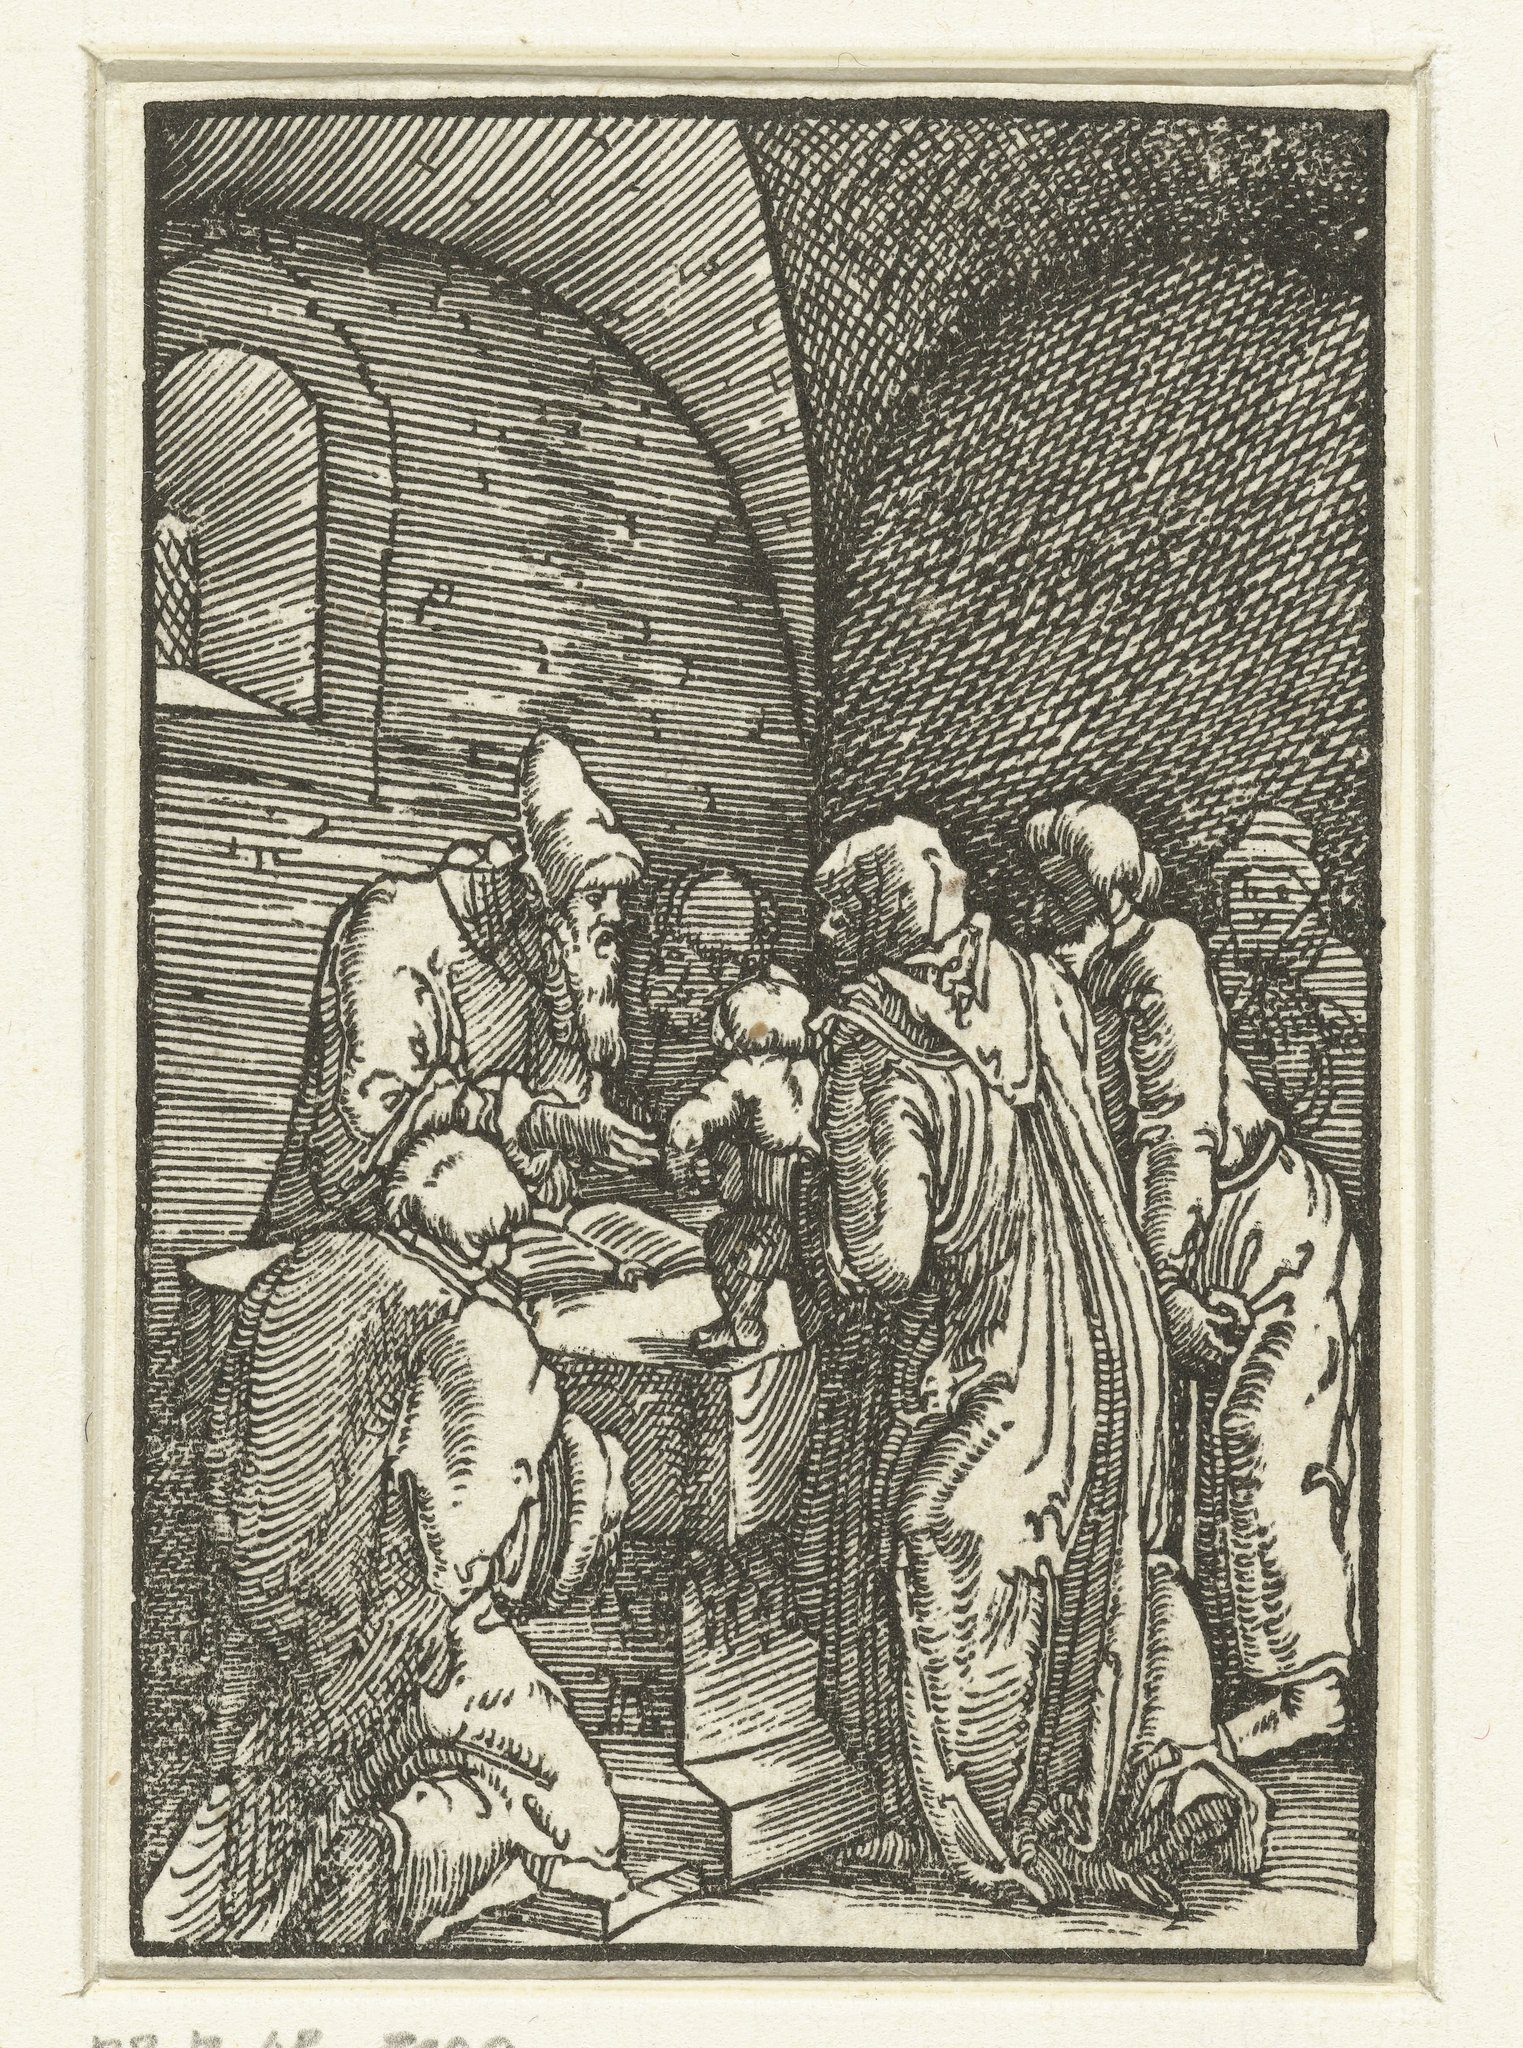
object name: print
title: De val en verlossing van de mensheid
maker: albrecht altdorfer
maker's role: draughtsman, print maker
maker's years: 1480-1538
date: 1506-1538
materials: paper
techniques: woodcut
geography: germany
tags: presentation of the christ-child in the temple, usually simeon (and anna) present (luke 2:22-39)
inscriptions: number: ‘58’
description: Maria met het Christuskind in haar handen, staand bij het altaar in de tempel. Een priester staat tegenover haar. Twaalfde prent uit een serie van veertig.